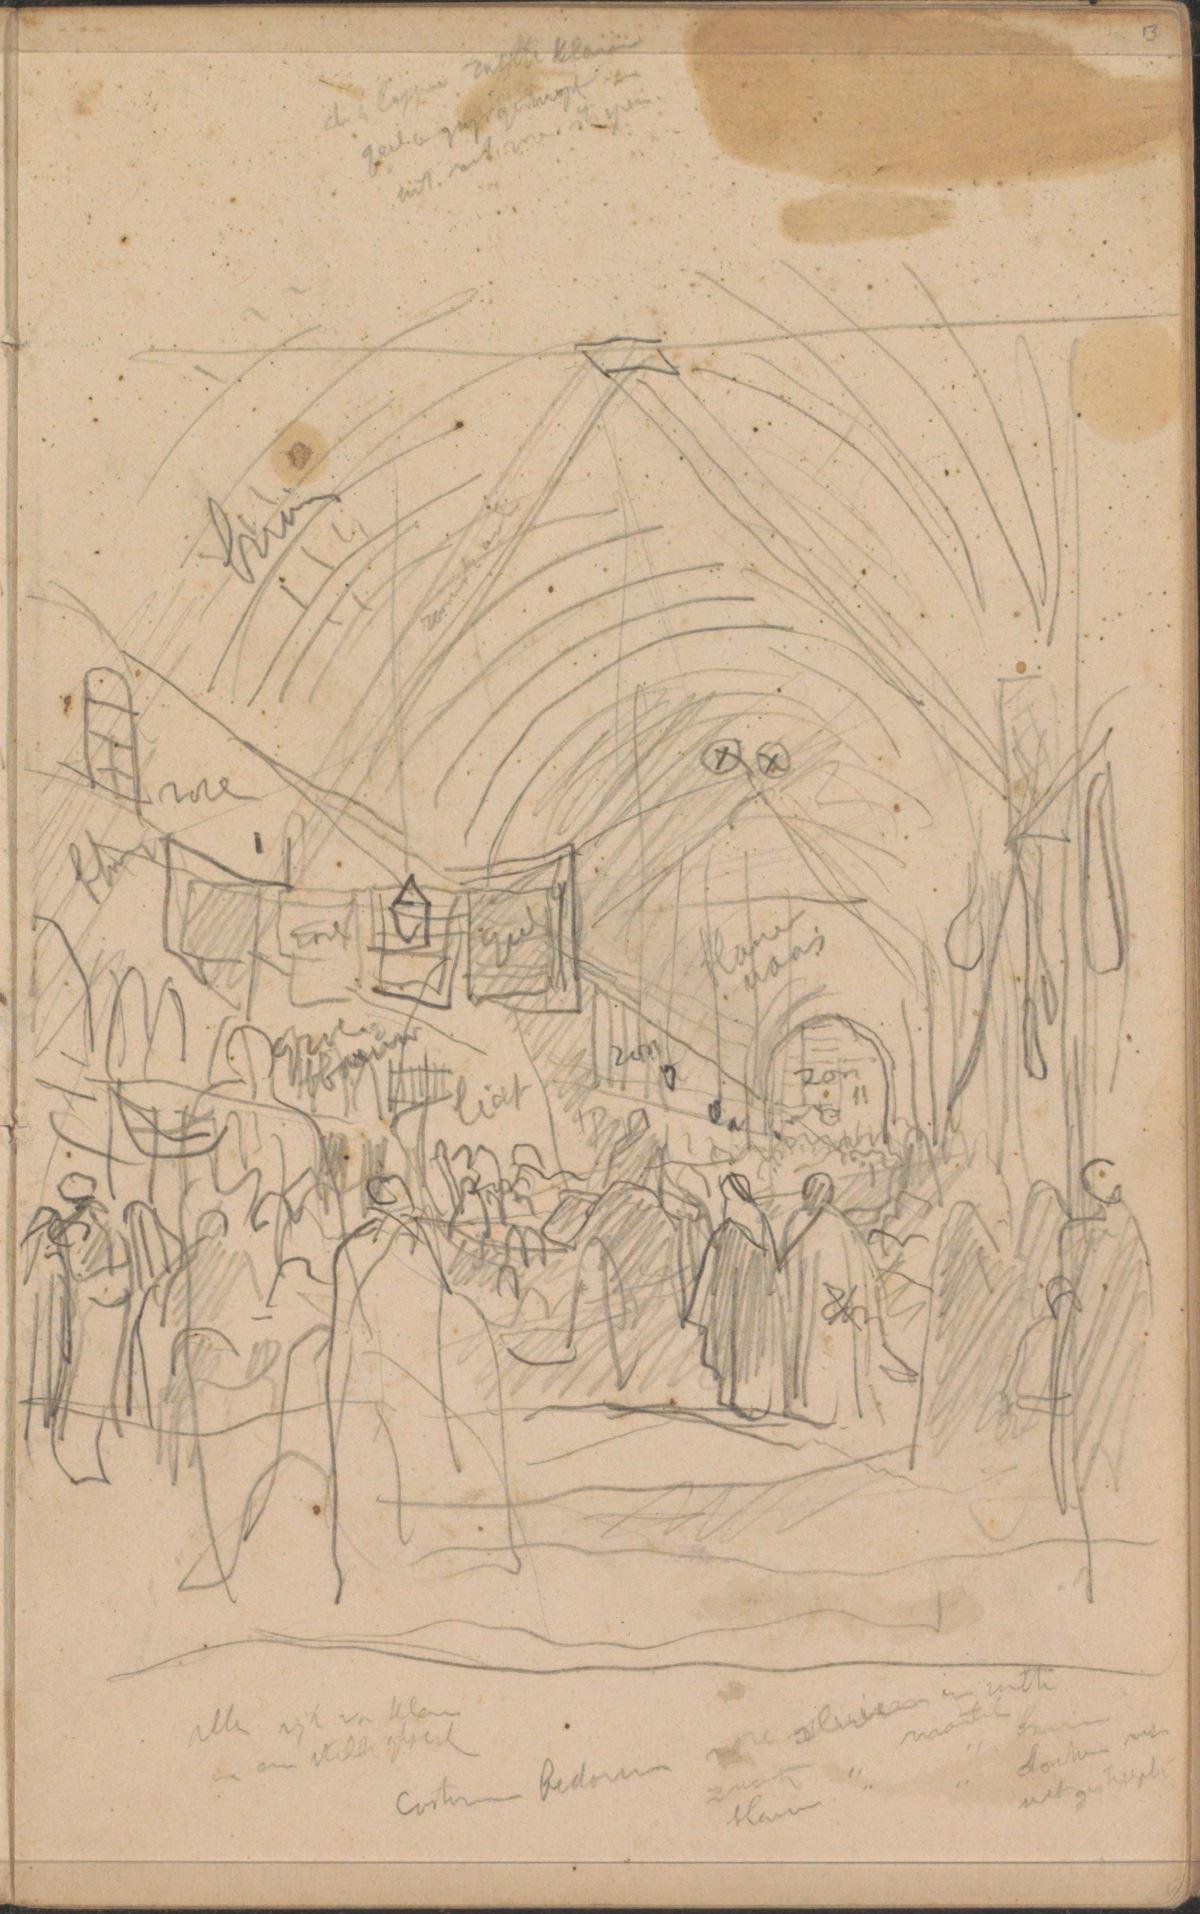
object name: sketchbook leaf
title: Overdekte straat met figuren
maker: marius bauer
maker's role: draughtsman, print maker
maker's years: 1867-1932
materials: paper, pencil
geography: jerusalem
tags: locations for trading, street (+ city(-scape) with figures, staffage)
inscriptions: kleurnotitie, handgeschreven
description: Mogelijk een markt of bazar. Pagina 13 uit een schetsboek met 36 bladen.